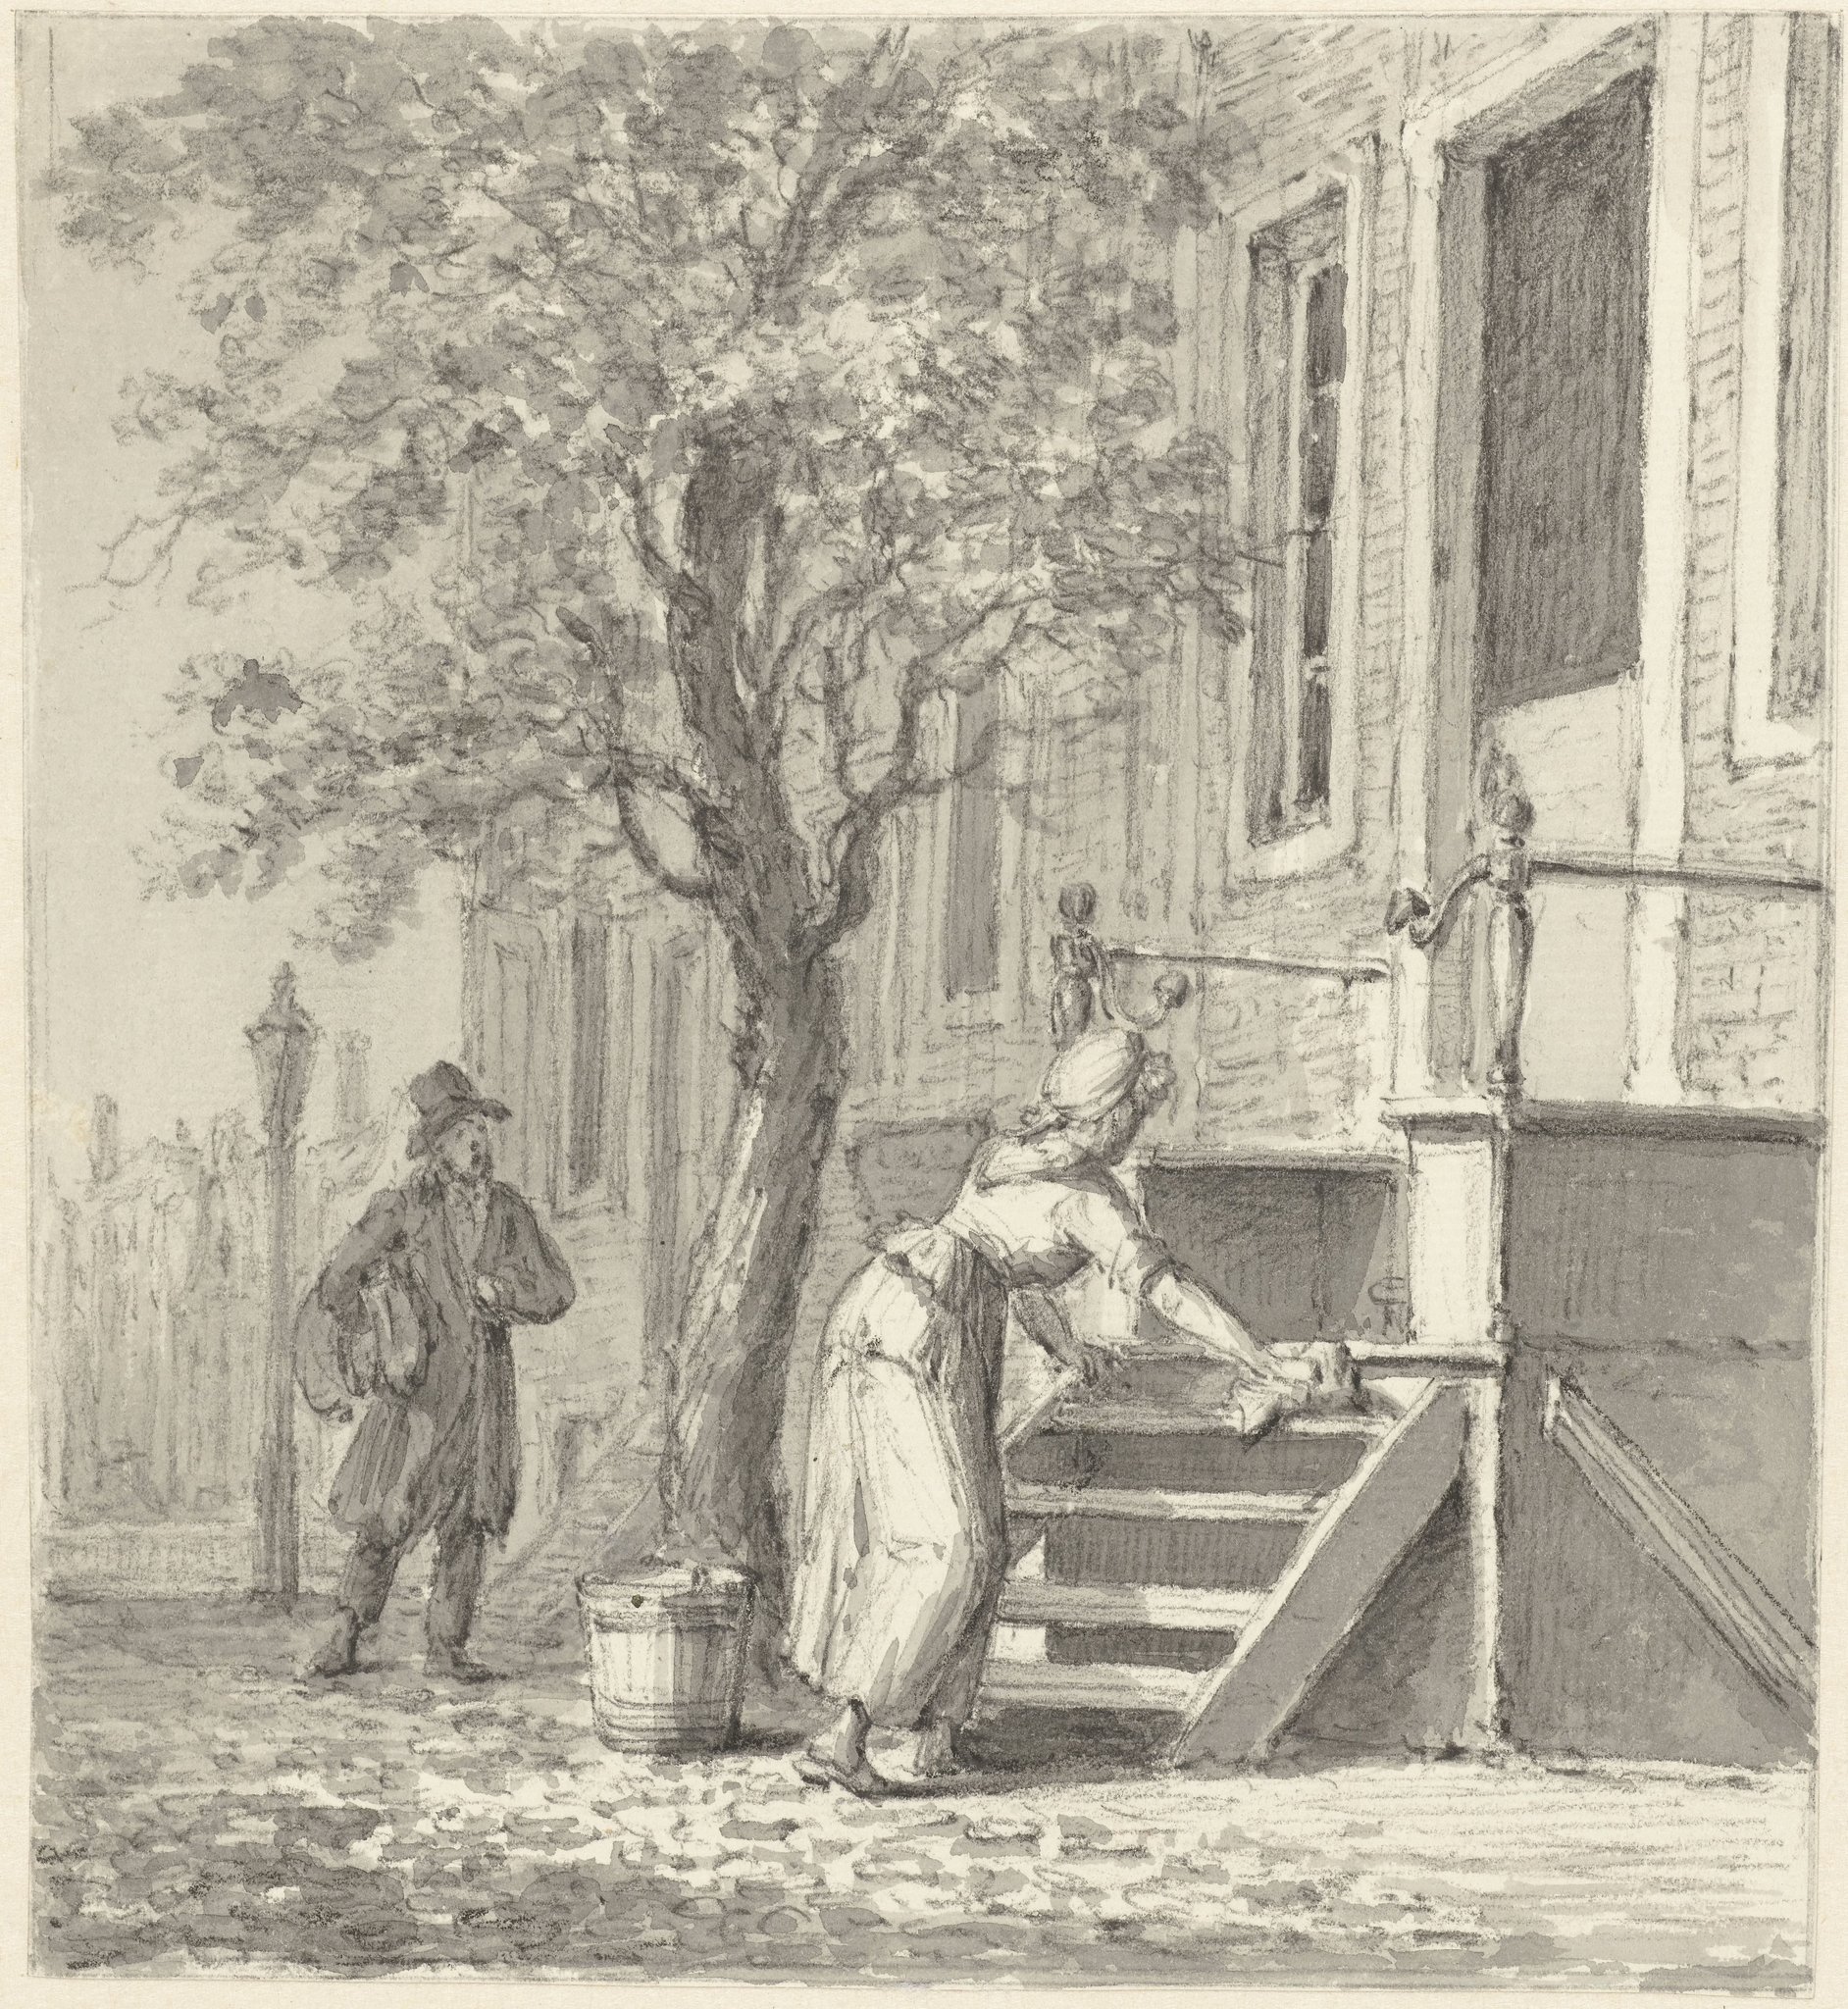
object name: drawing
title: Een dienstmeid bezig een trap voor een huis schoon te maken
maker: johannes jelgerhuis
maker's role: draughtsman, painter, print maker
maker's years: 1770-1836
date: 1780-1836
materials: chalk, paper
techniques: brush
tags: cleaning (the house), maid ~ house personnel